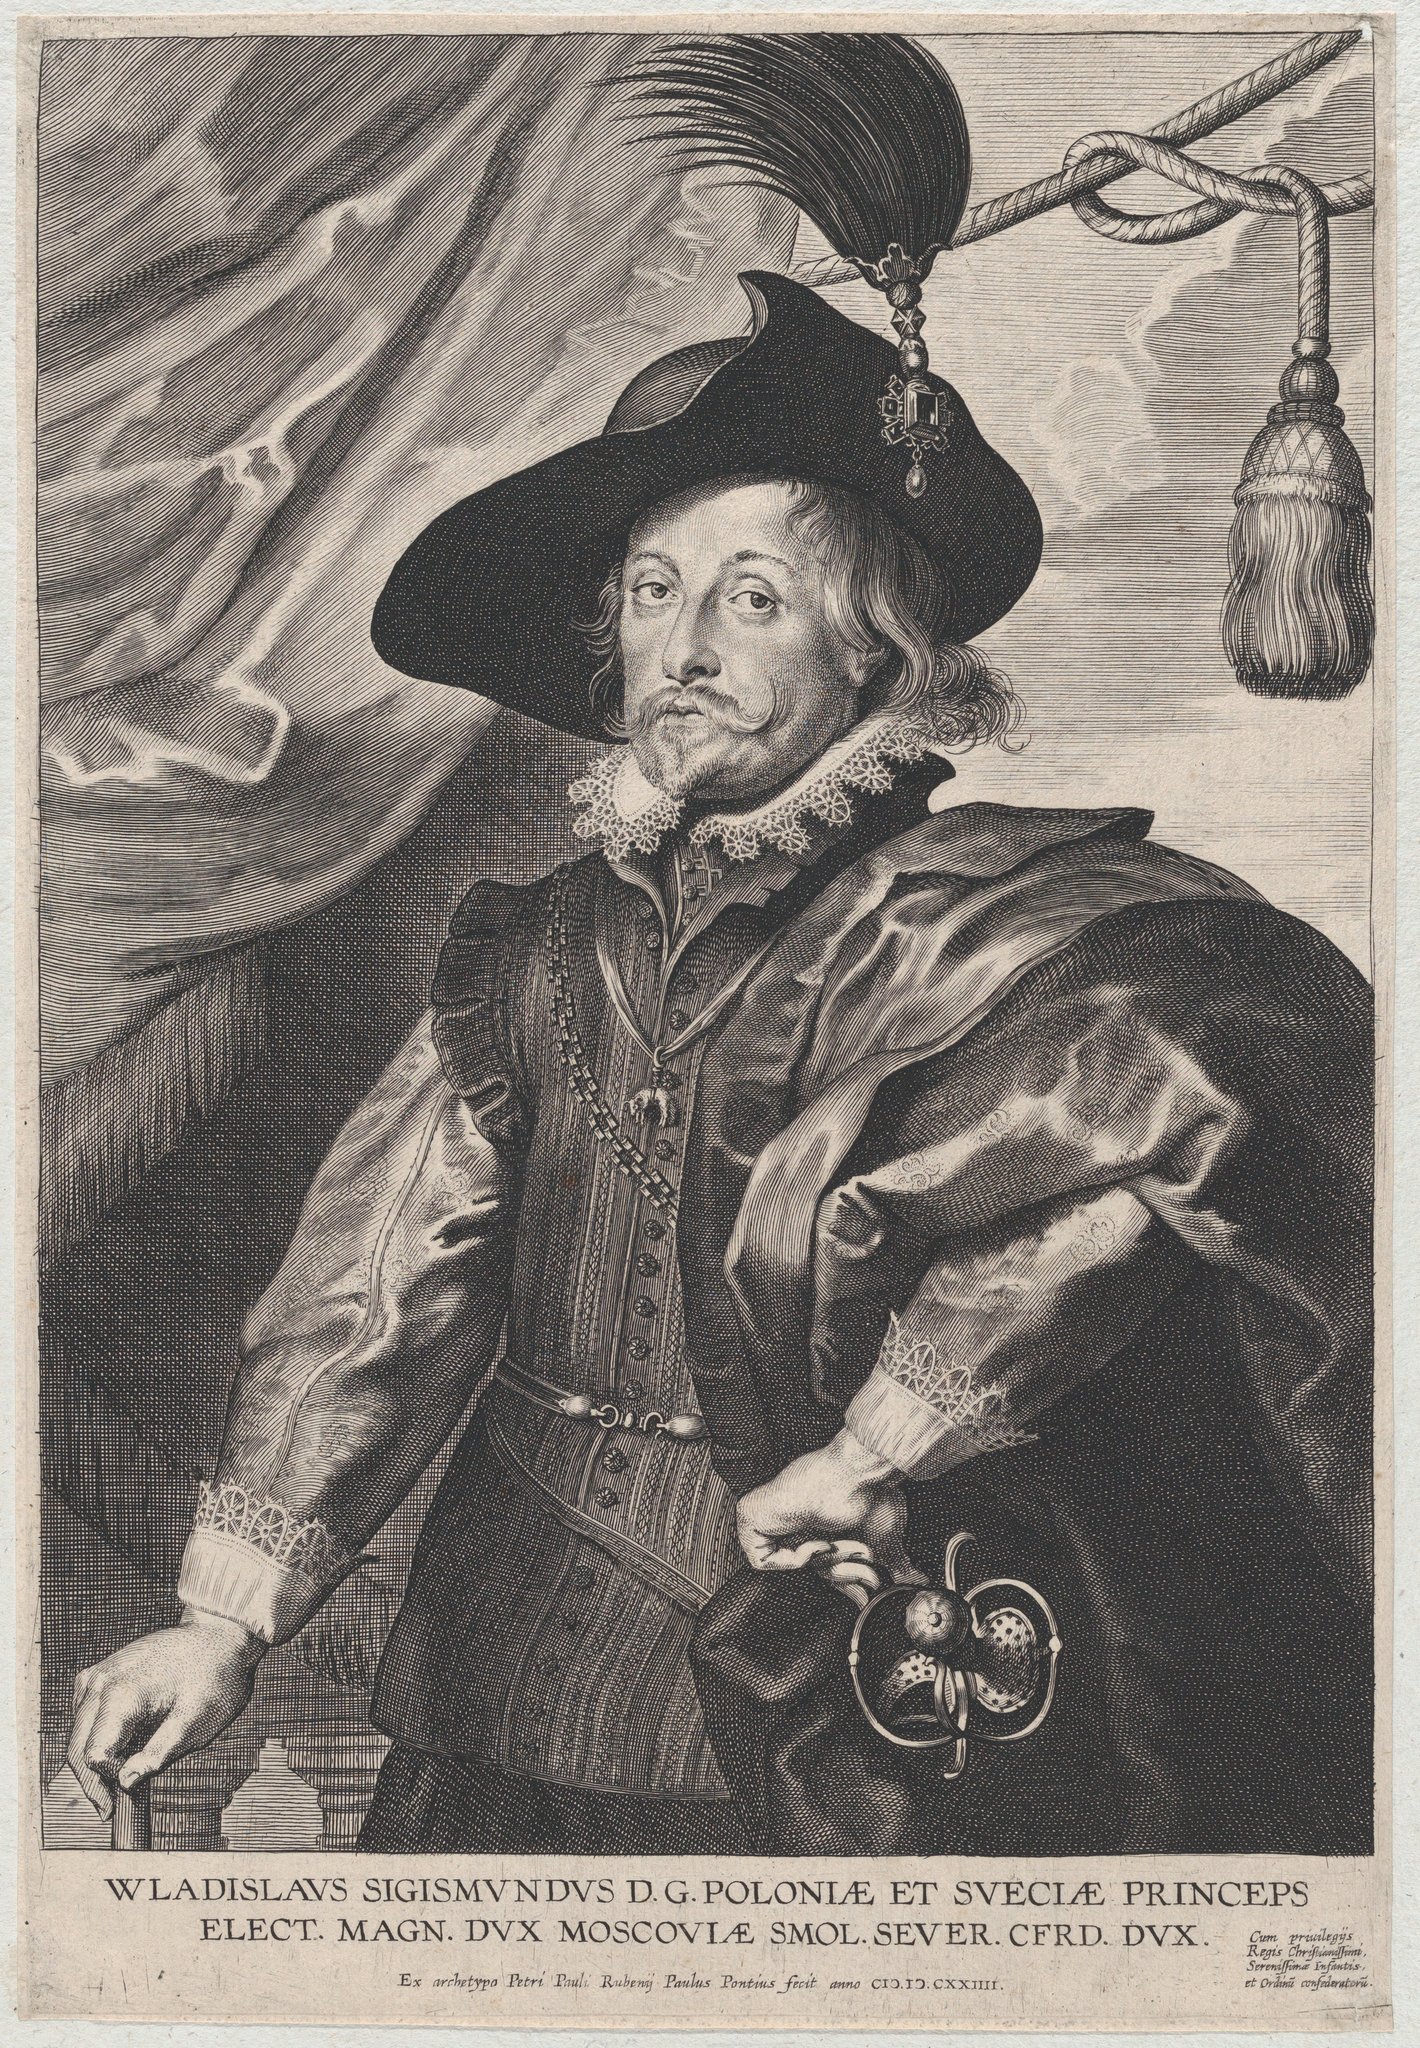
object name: print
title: Portrait of Wladislaus Sigismond, Prince of Poland and Sweden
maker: paulus pontius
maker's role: artist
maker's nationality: flemish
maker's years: 1603-1658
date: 1624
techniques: engraving, etching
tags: men,portraits